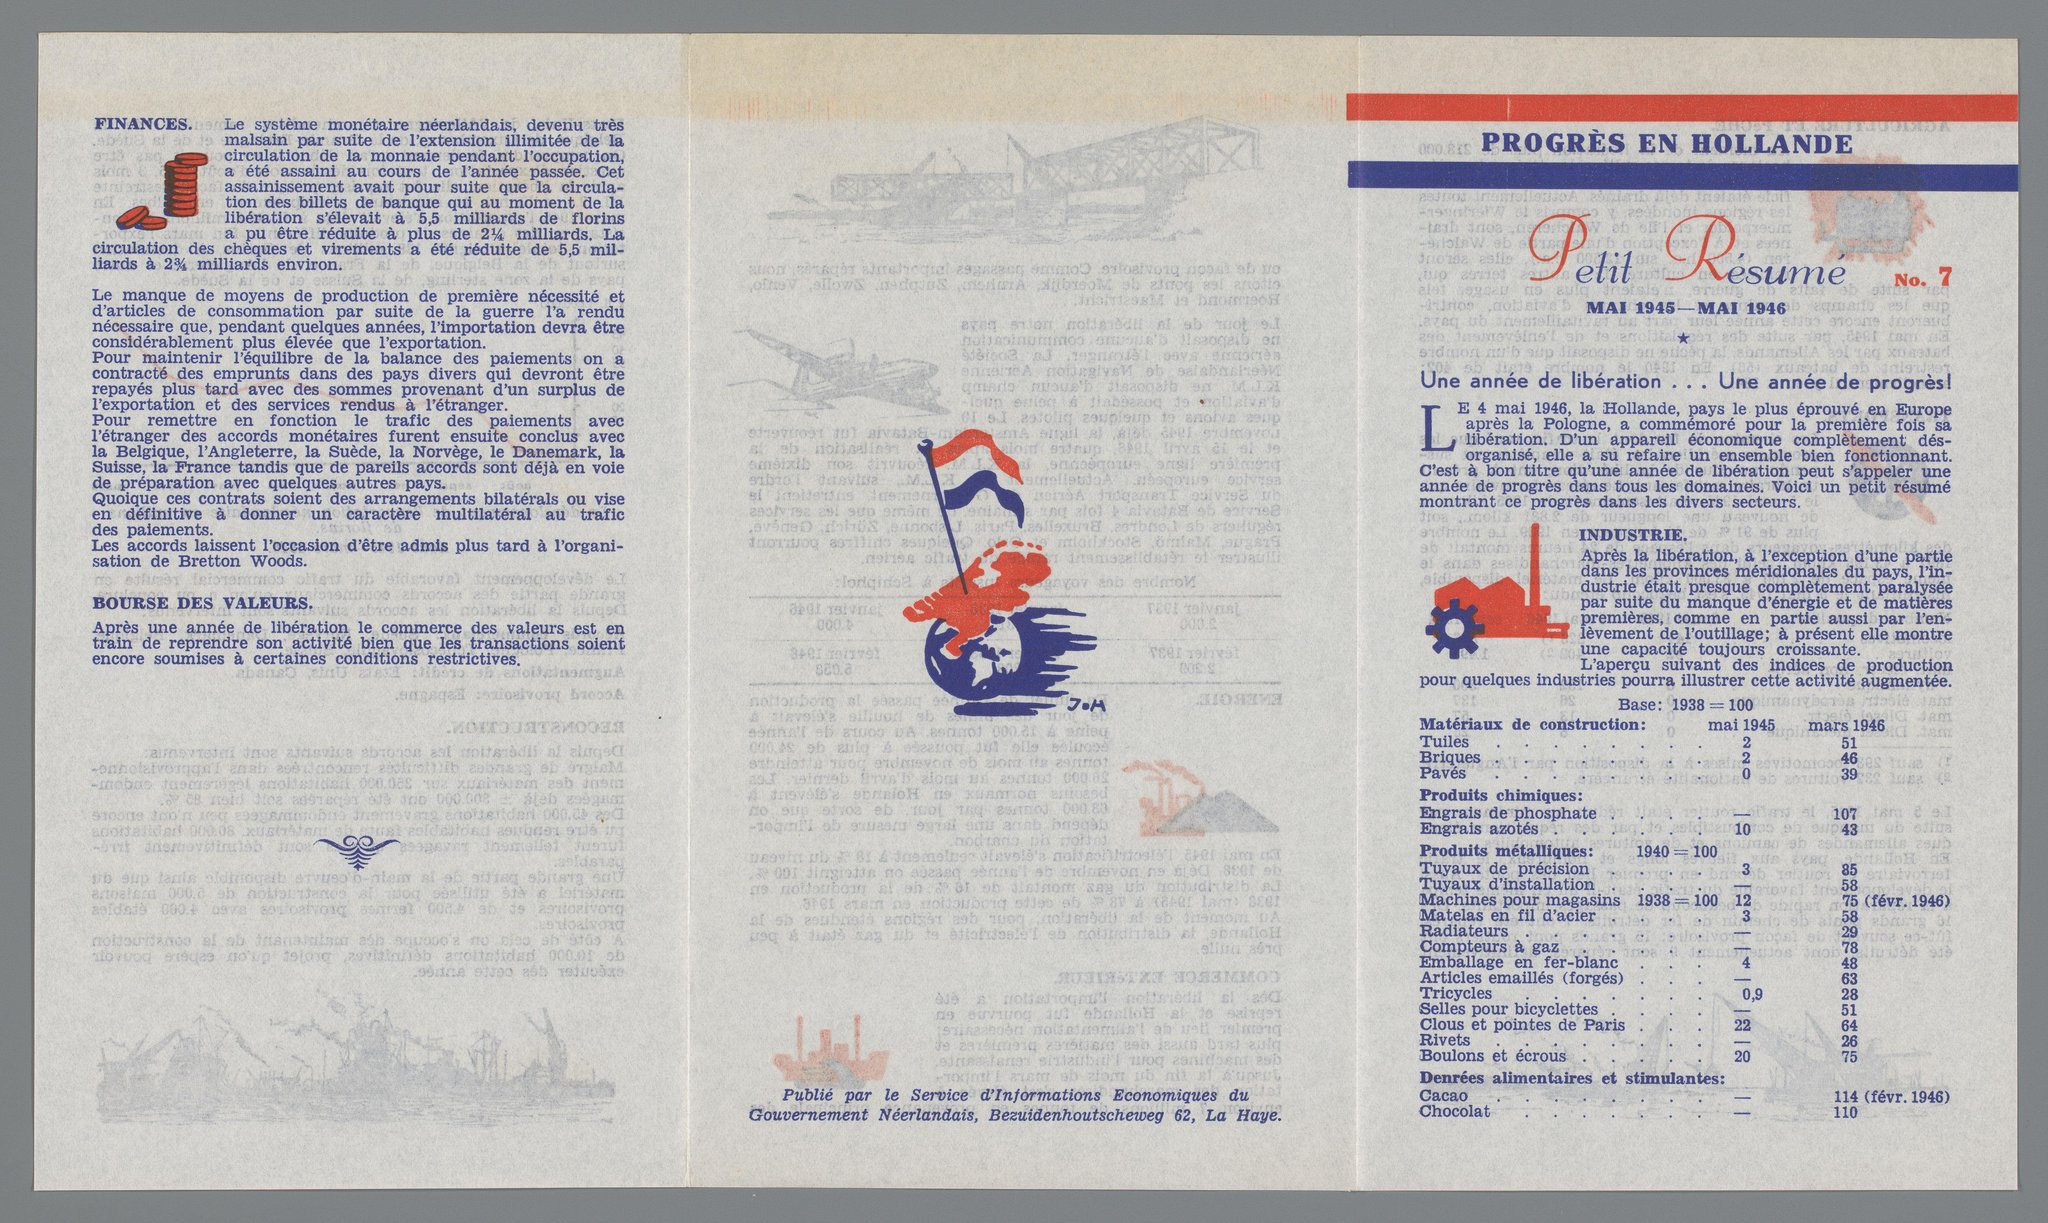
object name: document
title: Petit Résumé mai 1945 - mai 1946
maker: Anonymous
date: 1905-1946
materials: paper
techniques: letterpress printing, lithograph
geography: netherlands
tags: industries, netherlands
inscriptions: inscription: ‘Une année de libération ... Une année de progrès!/ Le 4 mai 1946, la Hollande, pays le plus éprouvé en Europe (...)’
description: Uitgave van het Ministerie van Financiën.